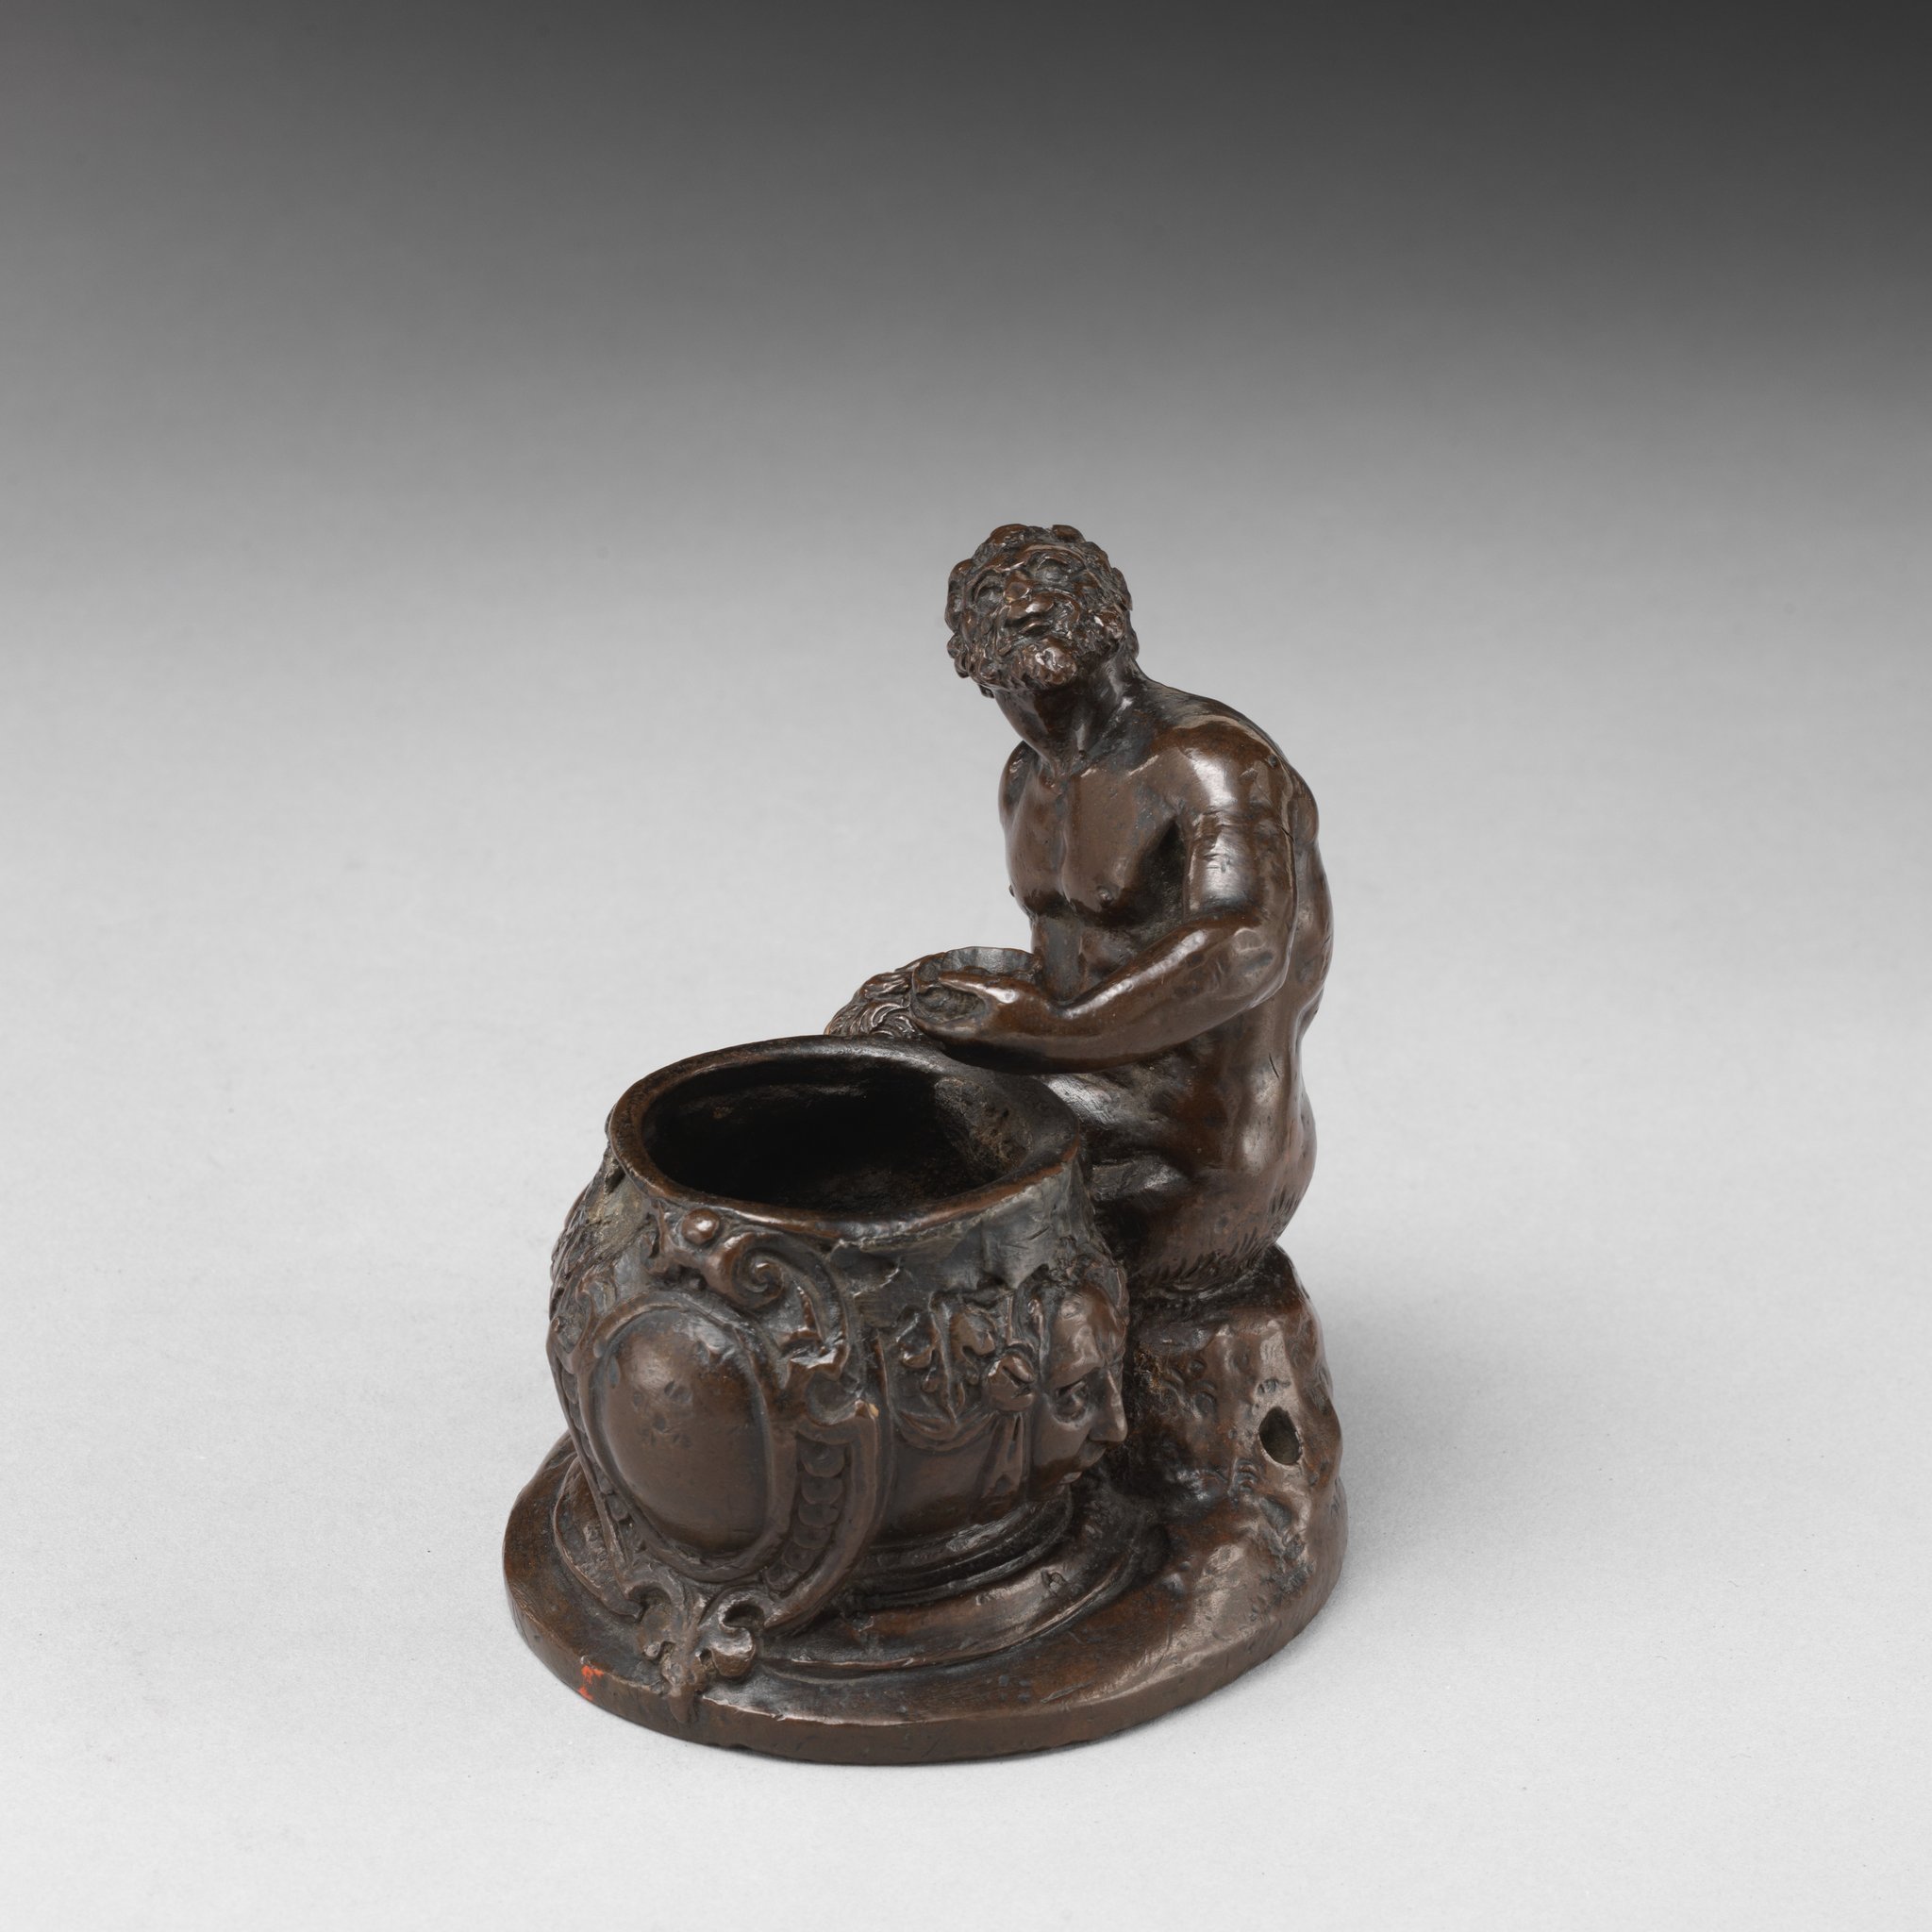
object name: inkwell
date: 1534-1566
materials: bronze, lacquer, patina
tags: fauns